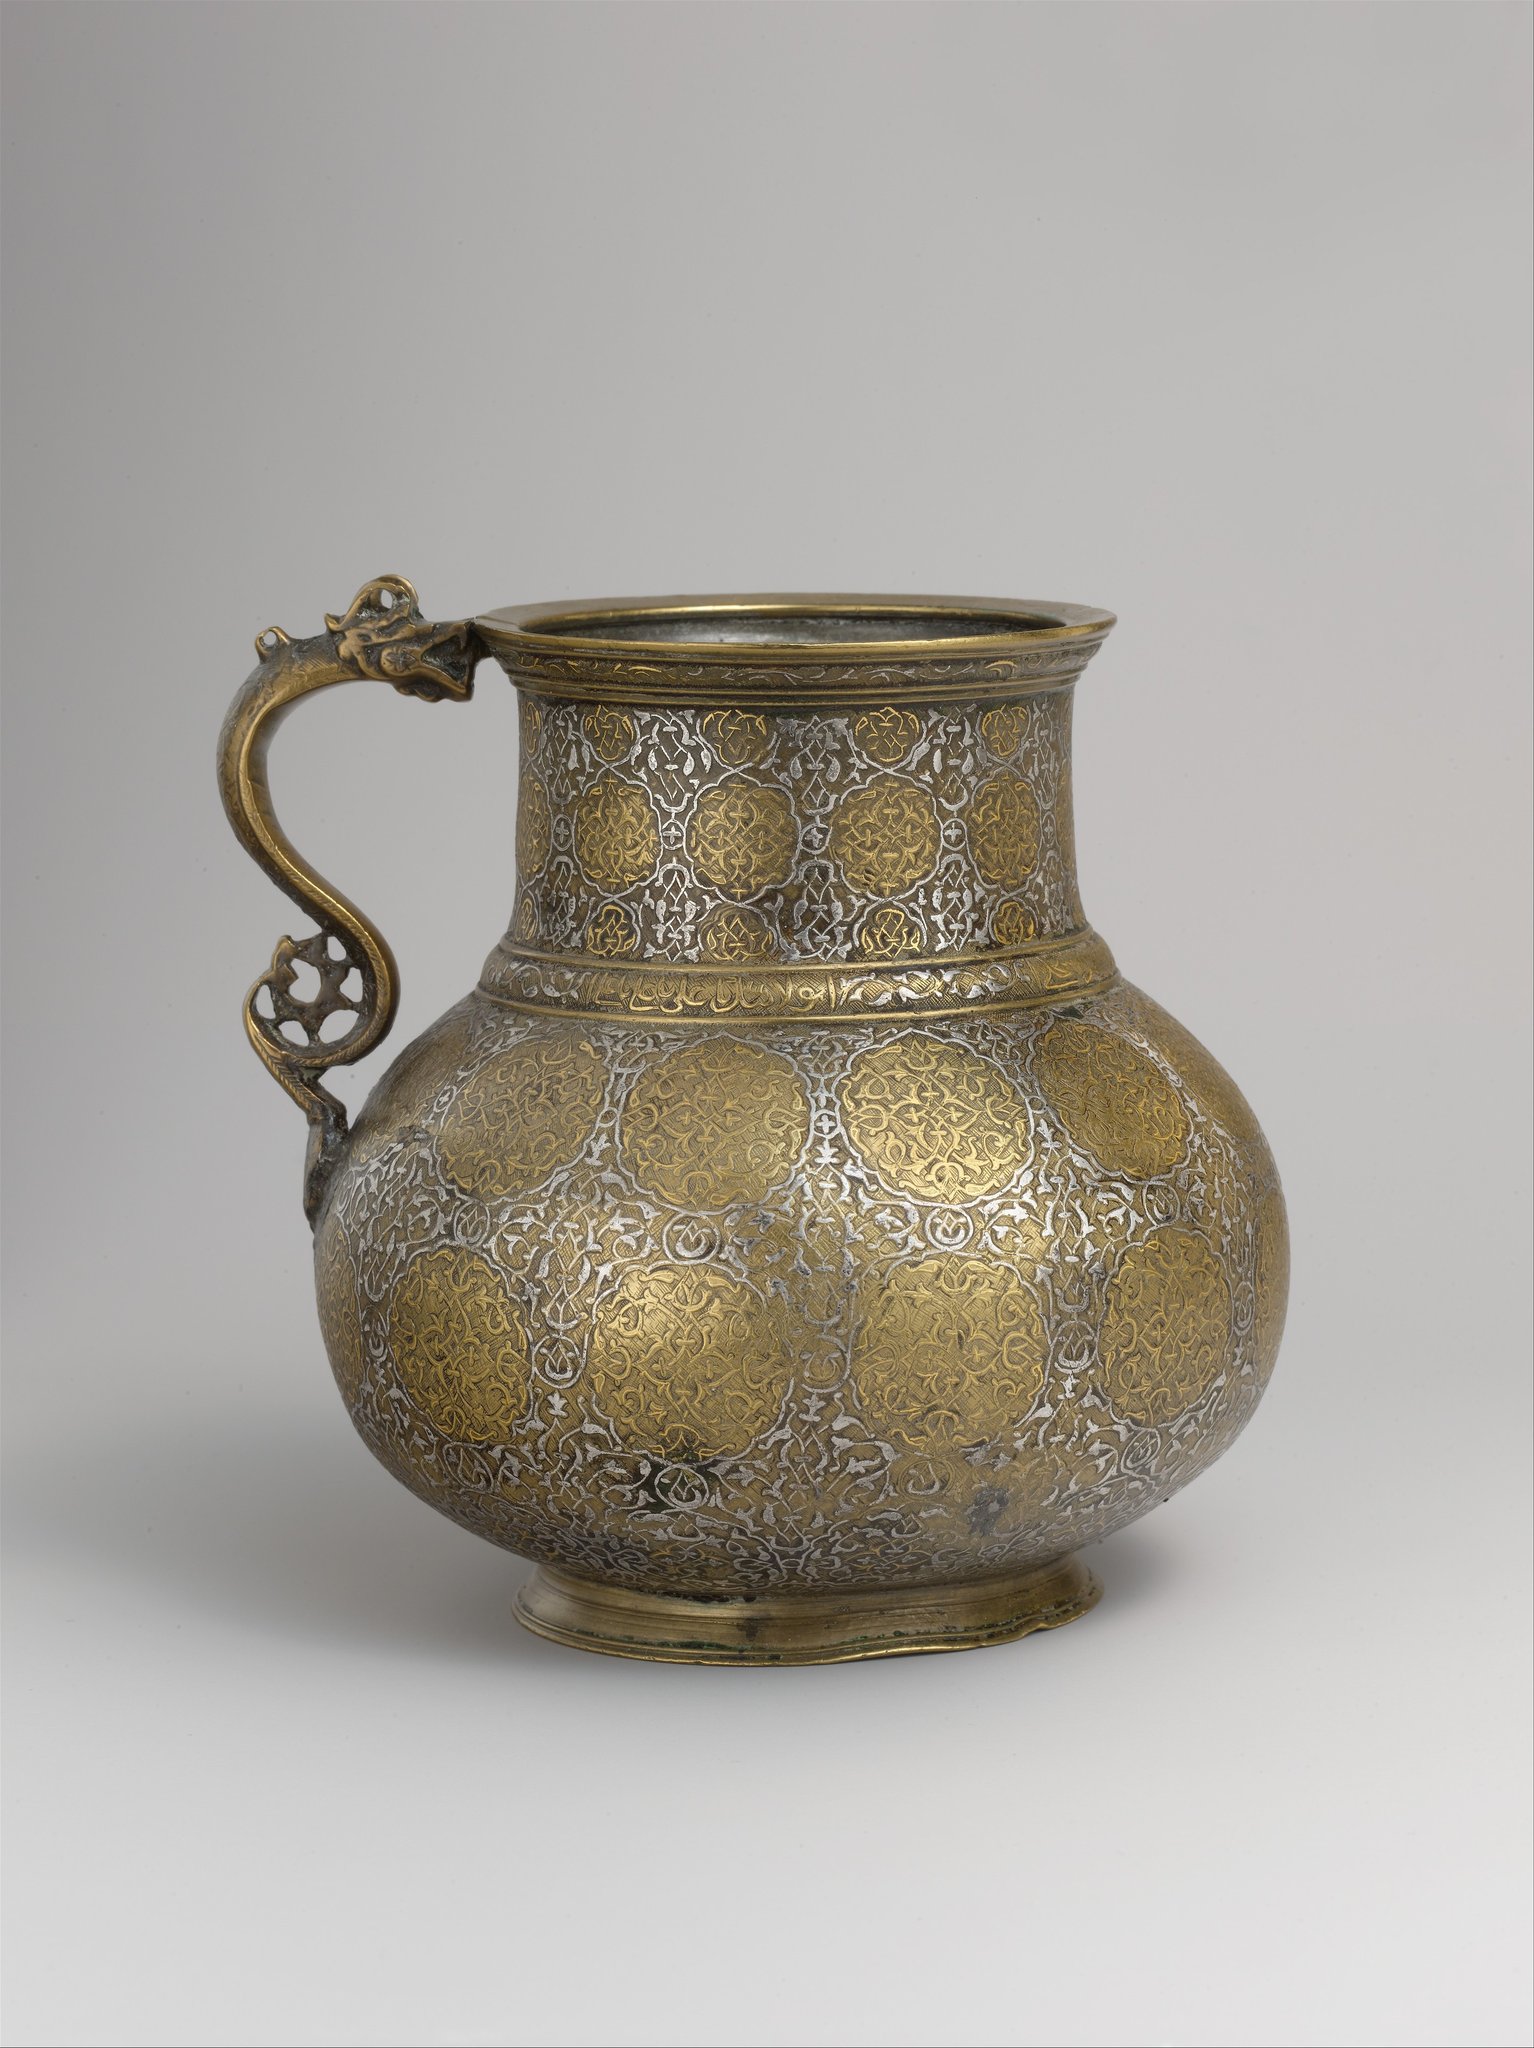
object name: jug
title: Dragon-Handled Jug with Inscription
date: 1501-1533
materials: brass, gold, silver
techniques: casting, engraving, inlay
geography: afghanistan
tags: arabic